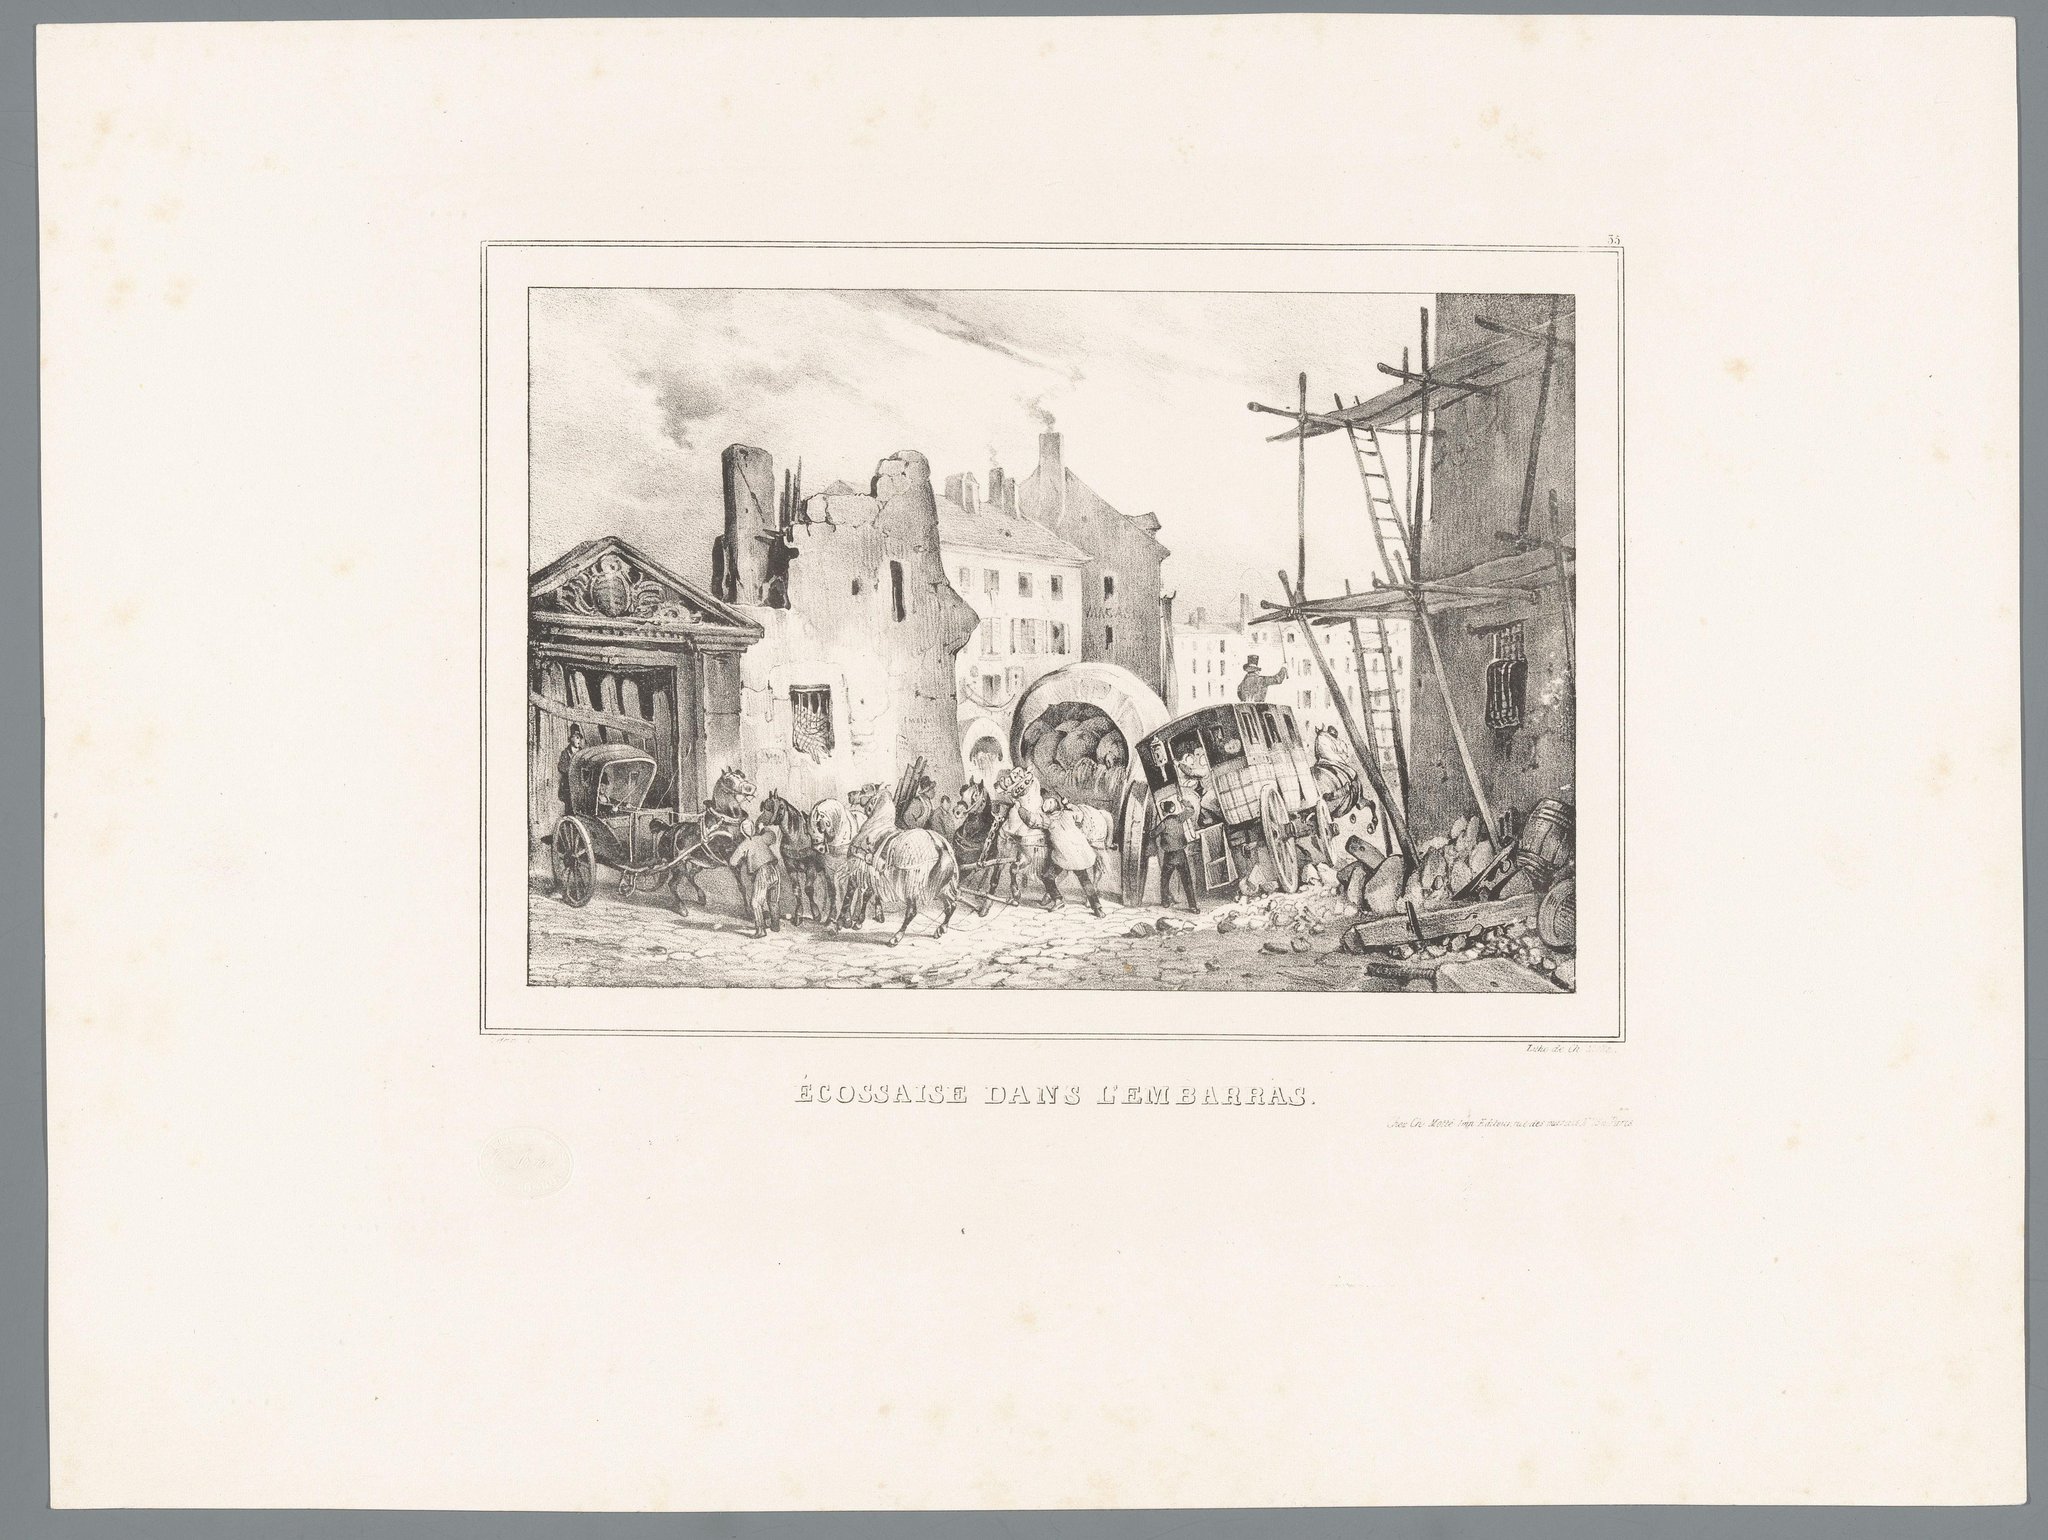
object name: print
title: Panidochème ou toutes sortes de voitures (3)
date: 1830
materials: paper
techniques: lithograph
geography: paris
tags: diligence, omnibus, horse-tram, four-wheeled vehicle drawn by two animals, (farm) wagon, freight wagon, cart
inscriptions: collector's mark: Lugt 2228, stamp: Lugt 1828b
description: De prentserie waar deze prent deel van uitmaakt werd in drie delen van twaalf prenten vanaf 1827 tot en met 1830 gepubliceerd. Elk van de drie delen werd voorzien van een aparte omslag. De 'Écossaise'-omnibussen of 'Écossaises' reden vanaf 1829 in Parijs. Ze hoorden bij een van de vele omnibus-maatschappijen die in dat jaar werden opgericht en waren herkenbaar aan de Schotse ruit.